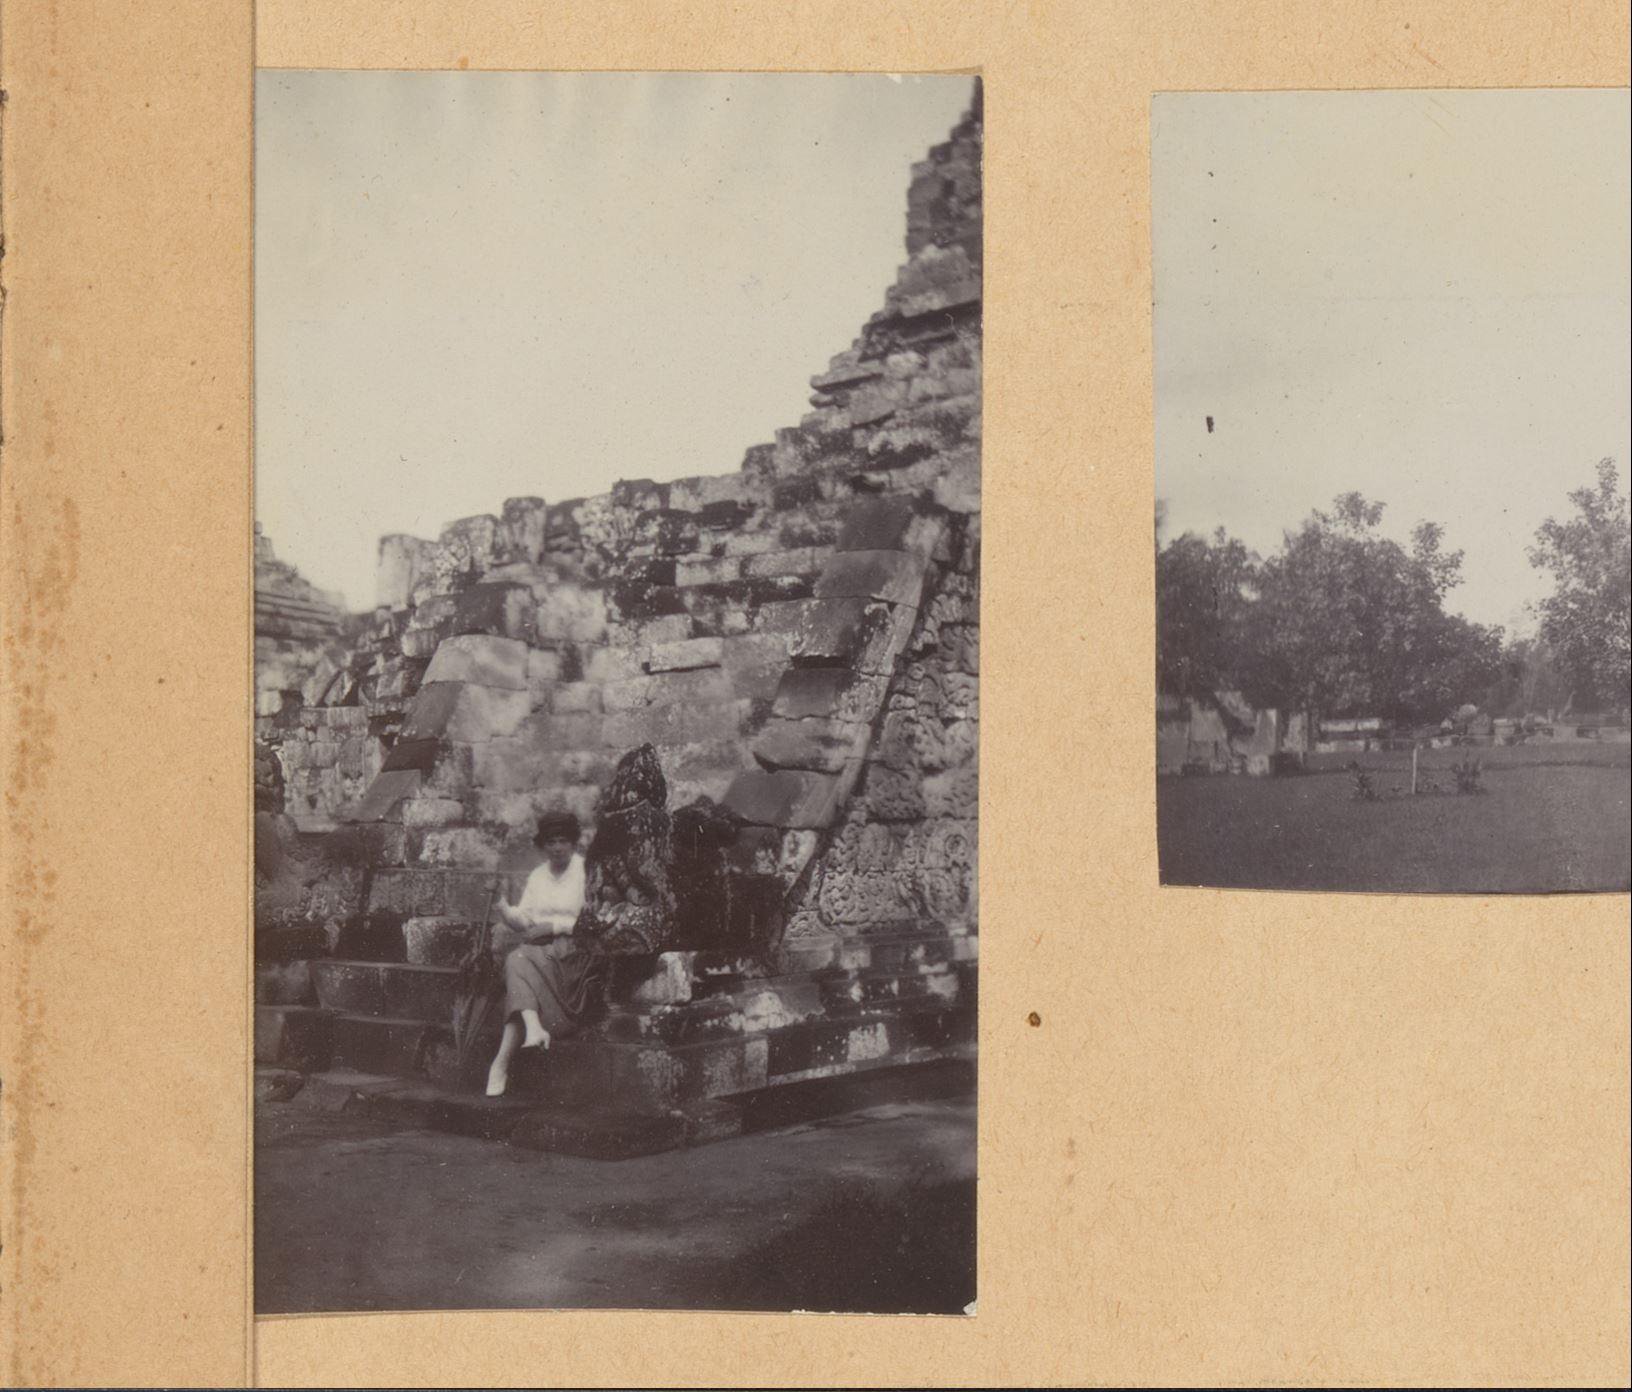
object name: photograph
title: Vrouw bij de ruïne van een bouwwerk, mogelijk de Borobudur op Java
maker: Anonymous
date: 1916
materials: photographic support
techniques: gelatin silver print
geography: borobudur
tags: temple, shrine ~ hinduism, buddhism, jainism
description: Onderdeel van Familiealbum met foto's van een familie in de voormalige kolonie Nederlands-Indië en van een suikerfabriek in Purworejo.